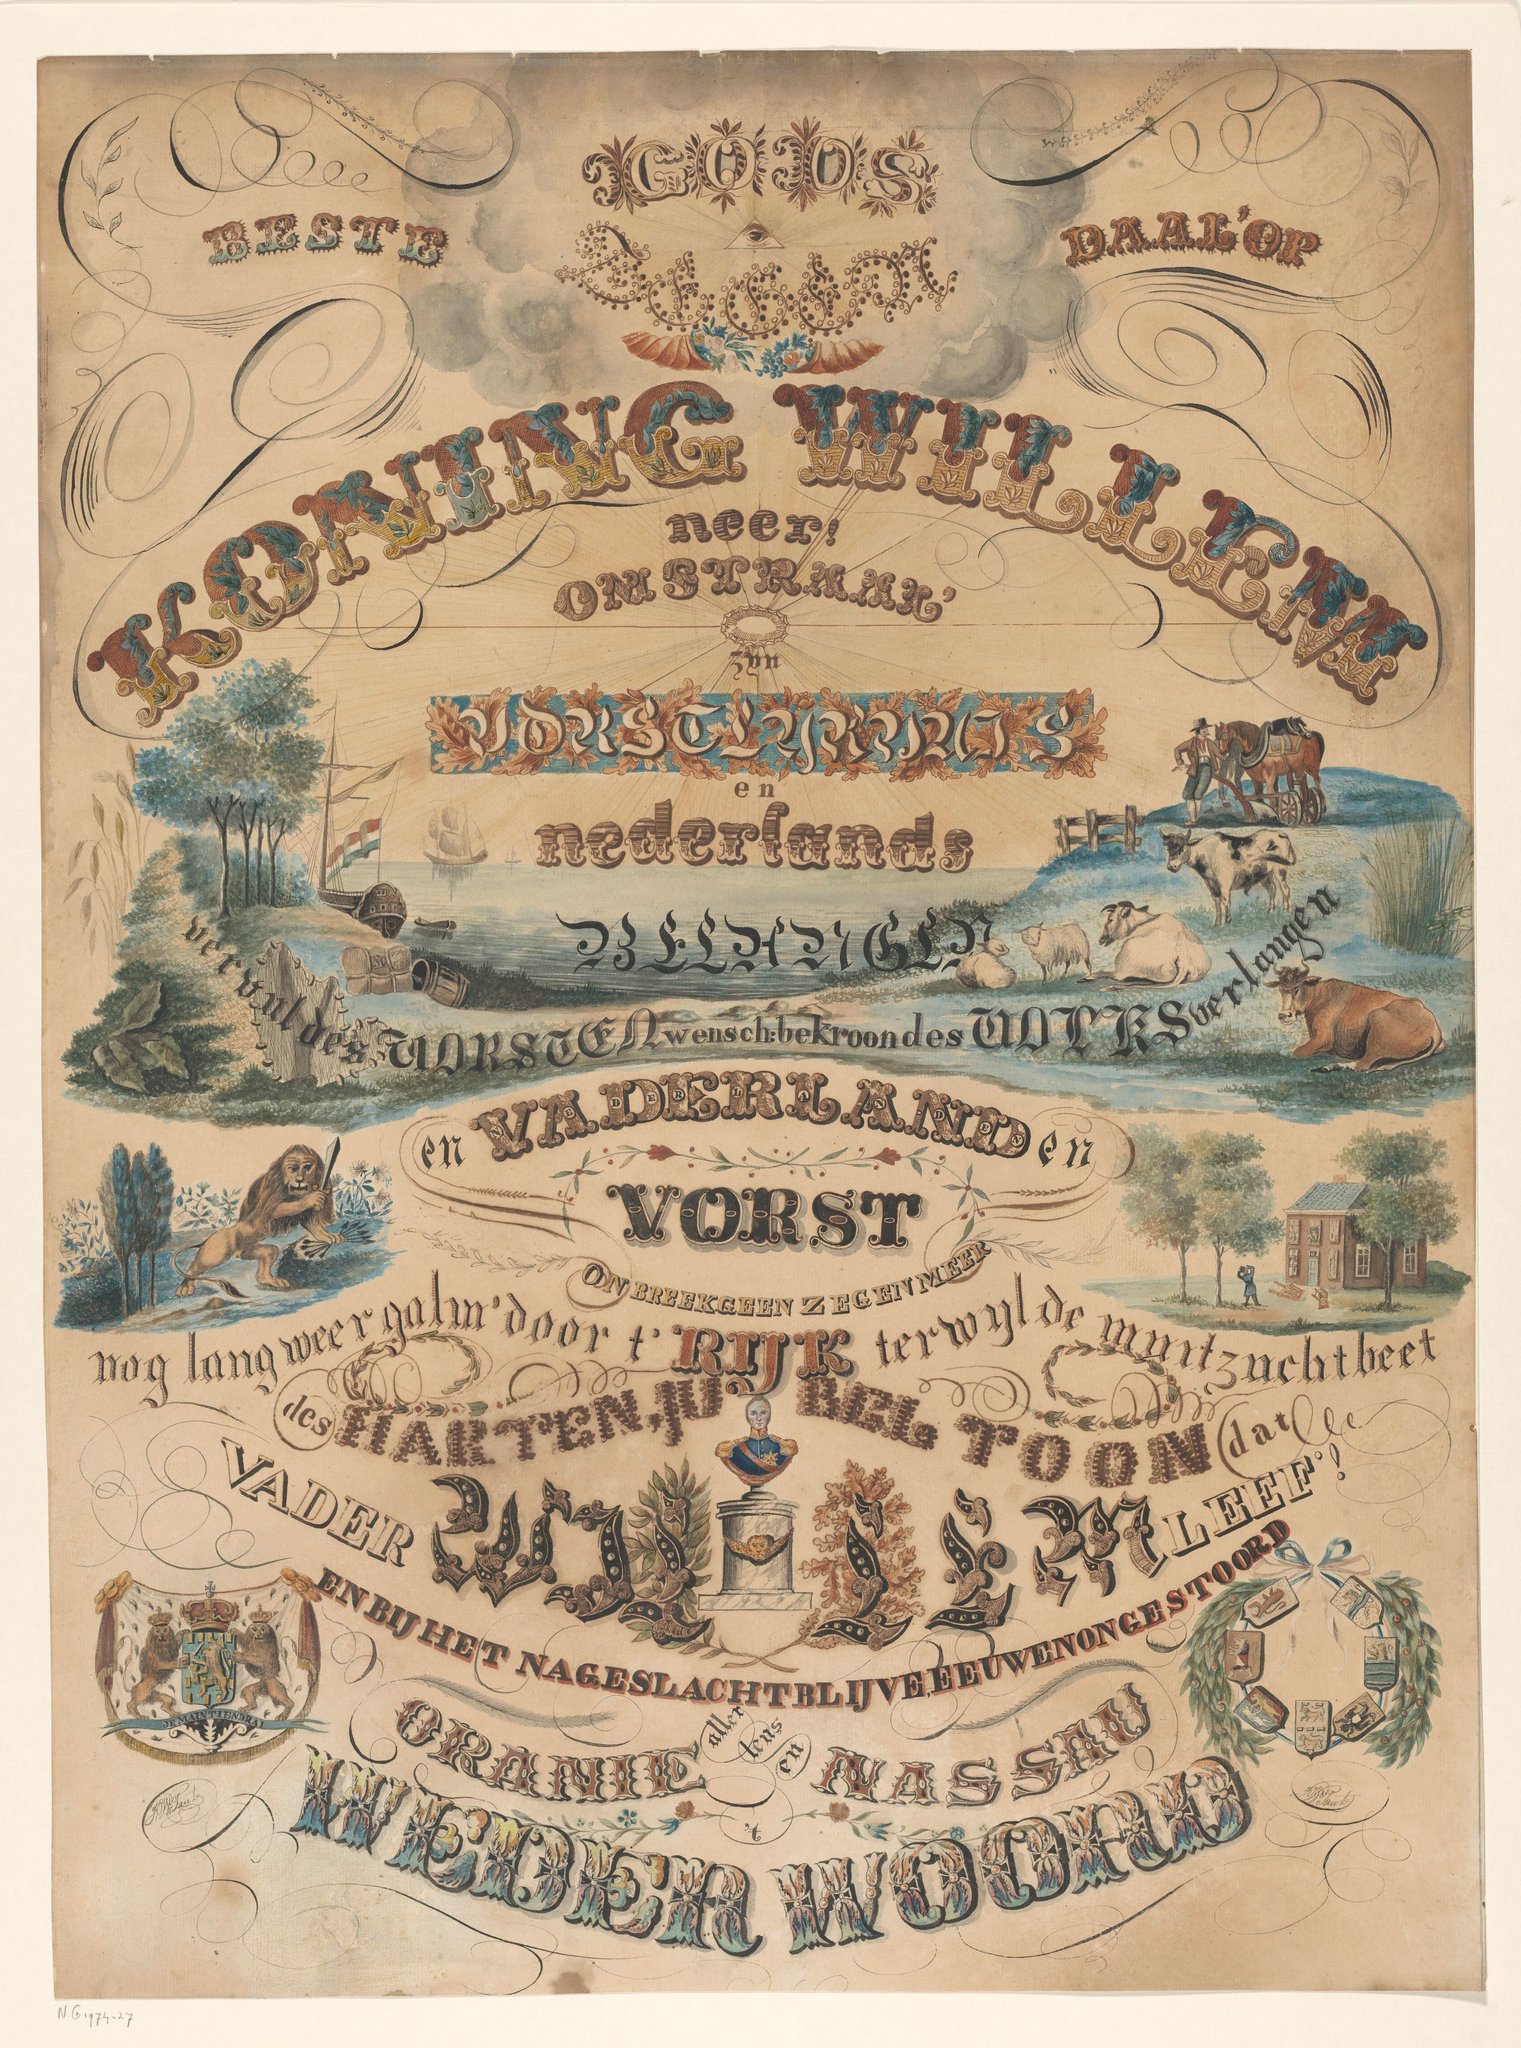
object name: calligraphy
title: Tekening en kalligrafie ter gelegenheid van de inhuldiging van koning Willem II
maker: j.w. taute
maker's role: draughtsman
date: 1840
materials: ink, paper, watercolor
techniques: brush, calligraphy, pen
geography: netherlands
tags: the hague, william ii of the netherlands, public festivities on the occasion of royal events, other forms of installation, calligraphy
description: Gekalligrafeerd blad papier, met verschillende lettertypes, en met verscheidene afbeeldingen: midden landschap met links enige schepen en rechts vee, daaronder links de Nederlandse leeuw en rechts een man bij een geplunderd huis, onder midden borstbeeld van de koning, links Nederlandse wapen en rechts lauwerkrans met zeven wapens. Opschrift: 'Gods beste zegen daal 'op Koning Willem neer!